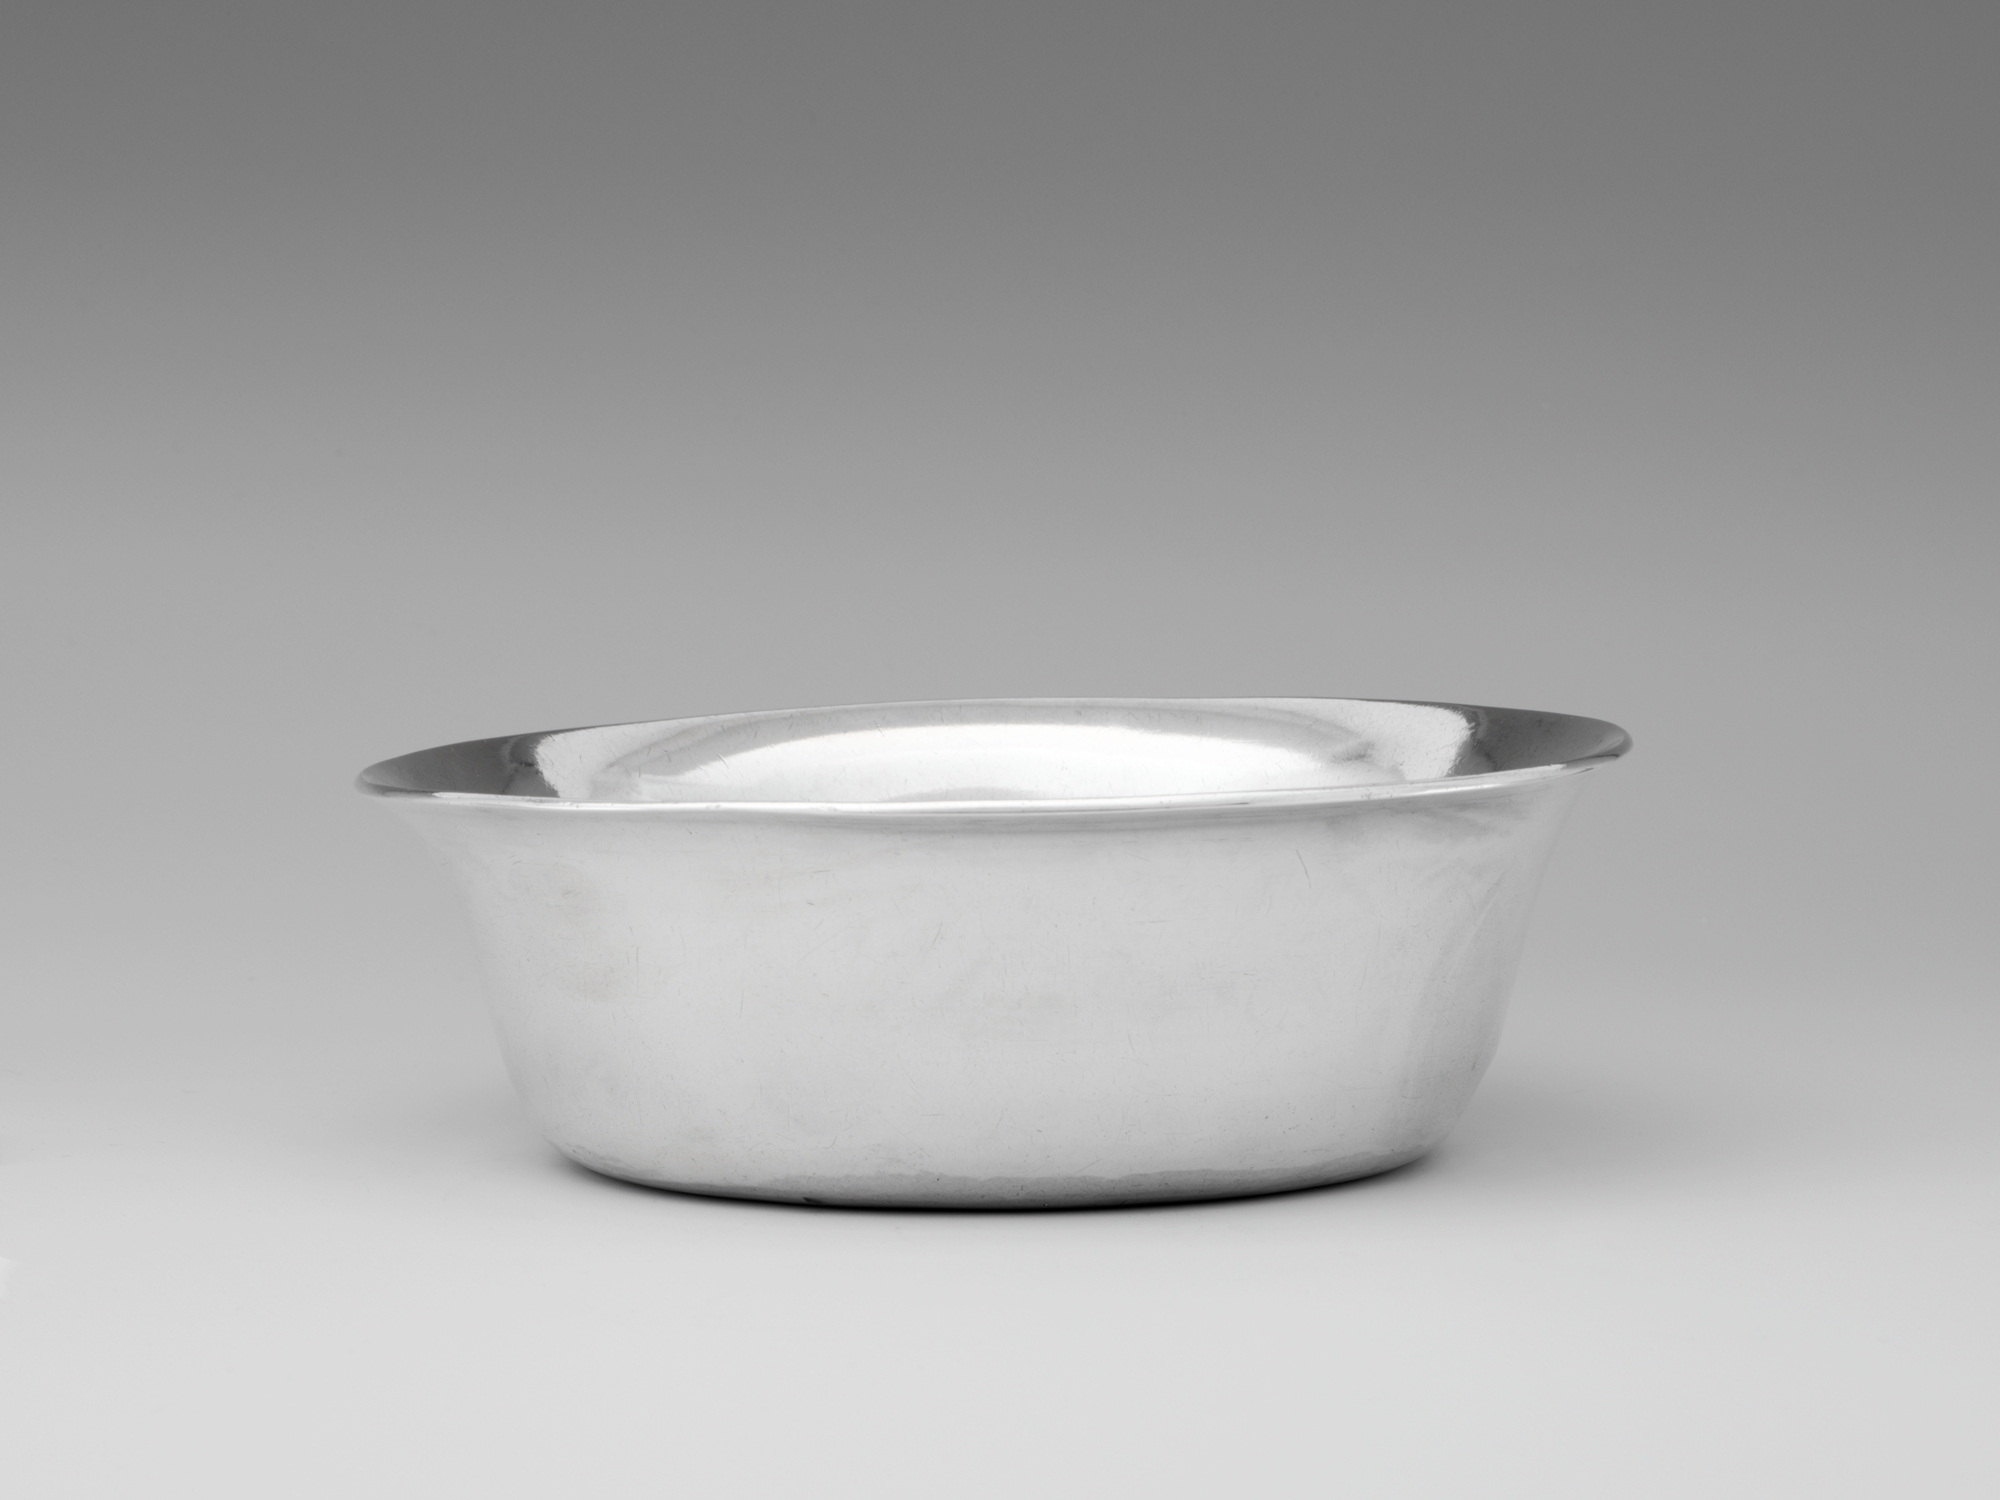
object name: dish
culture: american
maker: lewis fourniquet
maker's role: maker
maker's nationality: american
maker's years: 1791-1825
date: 1800-1830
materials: silver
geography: united states